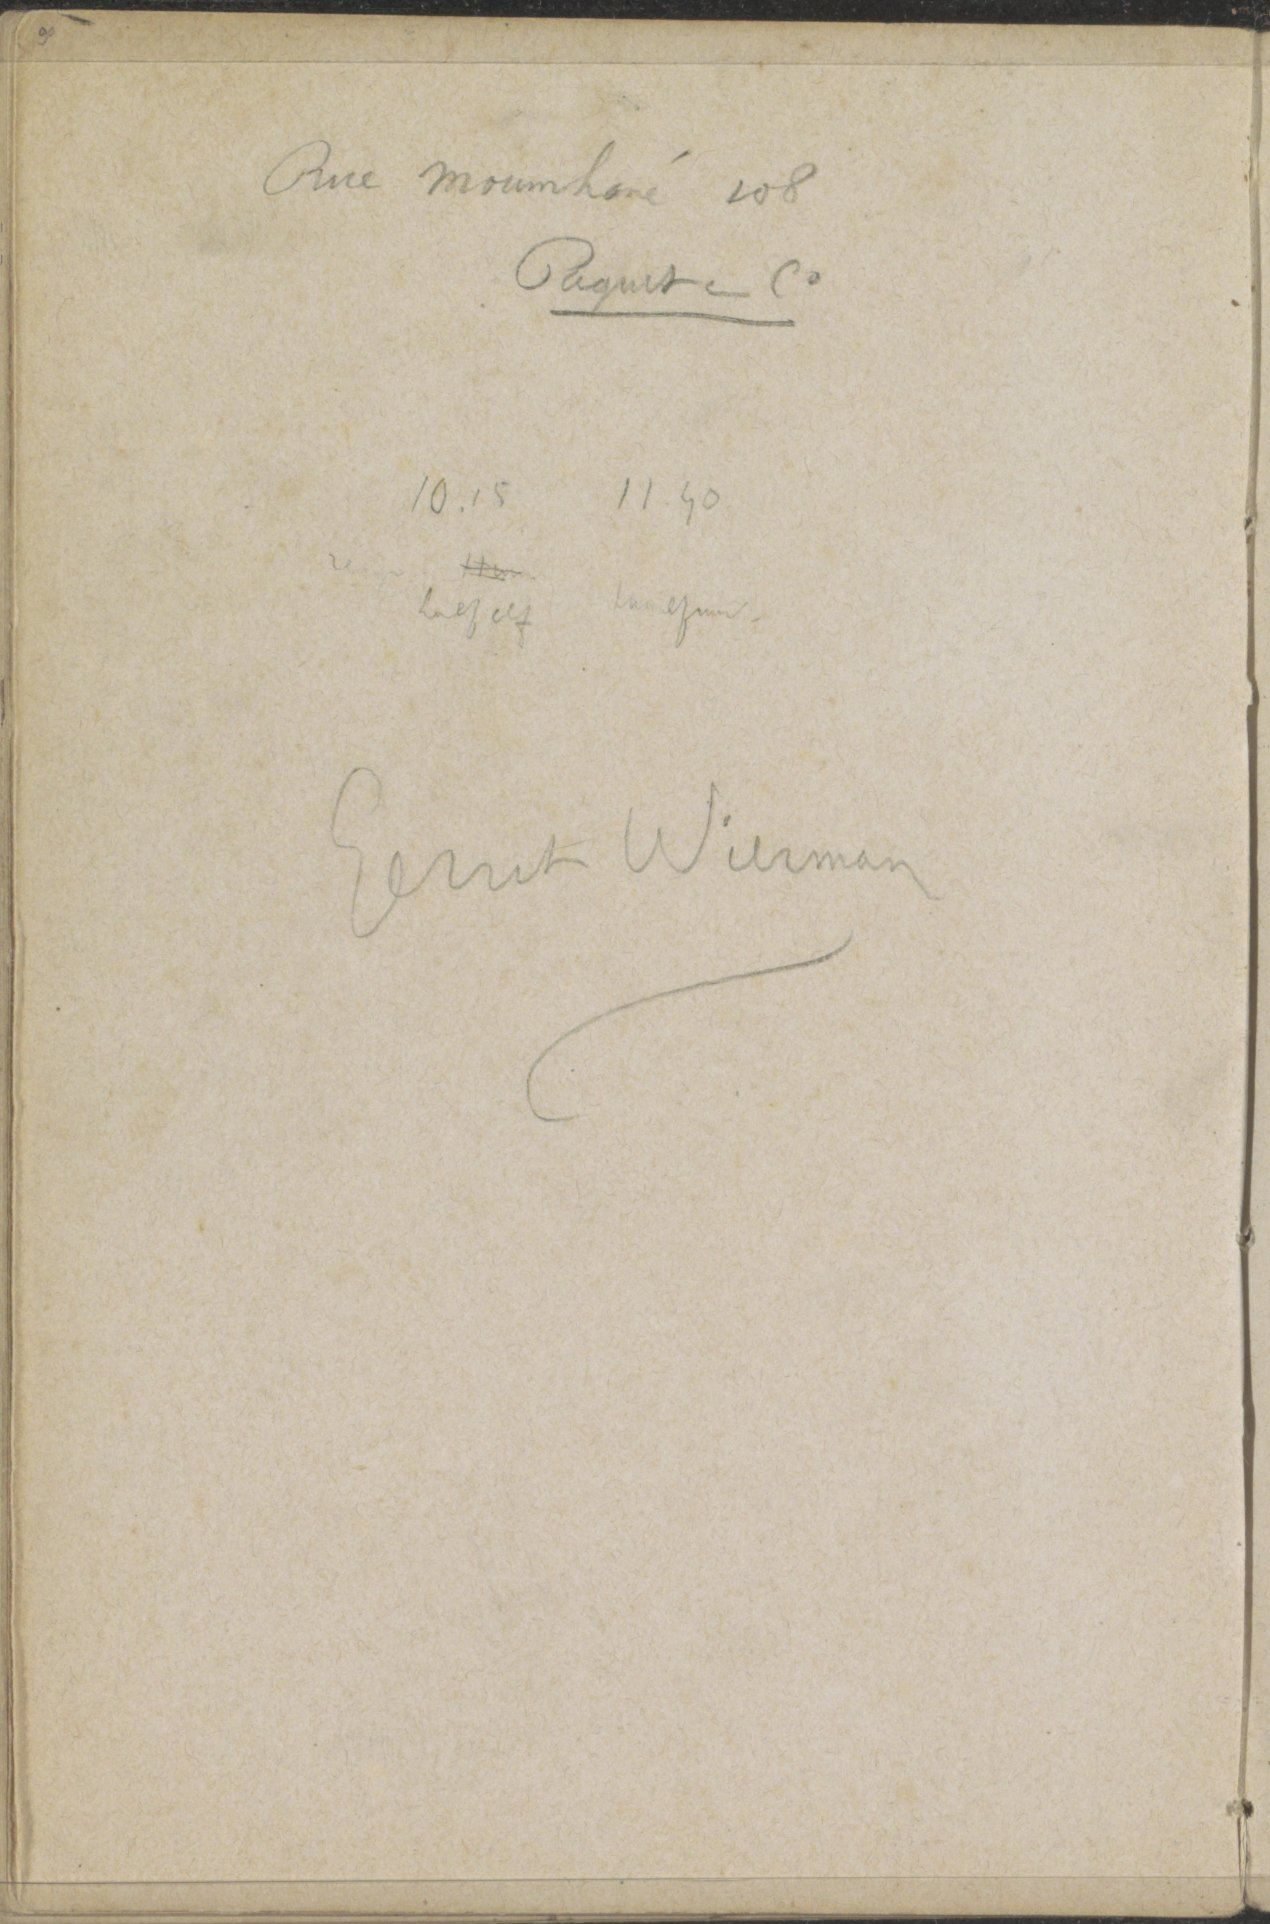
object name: sketchbook leaf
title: Blad met notities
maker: marius bauer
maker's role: draughtsman, print maker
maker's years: 1867-1932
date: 1896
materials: paper, pencil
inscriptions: annotation: ‘Rue Moumhoré 108/ Raquit en Co./ 10.15 11.40/ half elf twaalf uur/ Gerrit Wilzman’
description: Pagina 90 uit een schetsboek met 45 bladen.